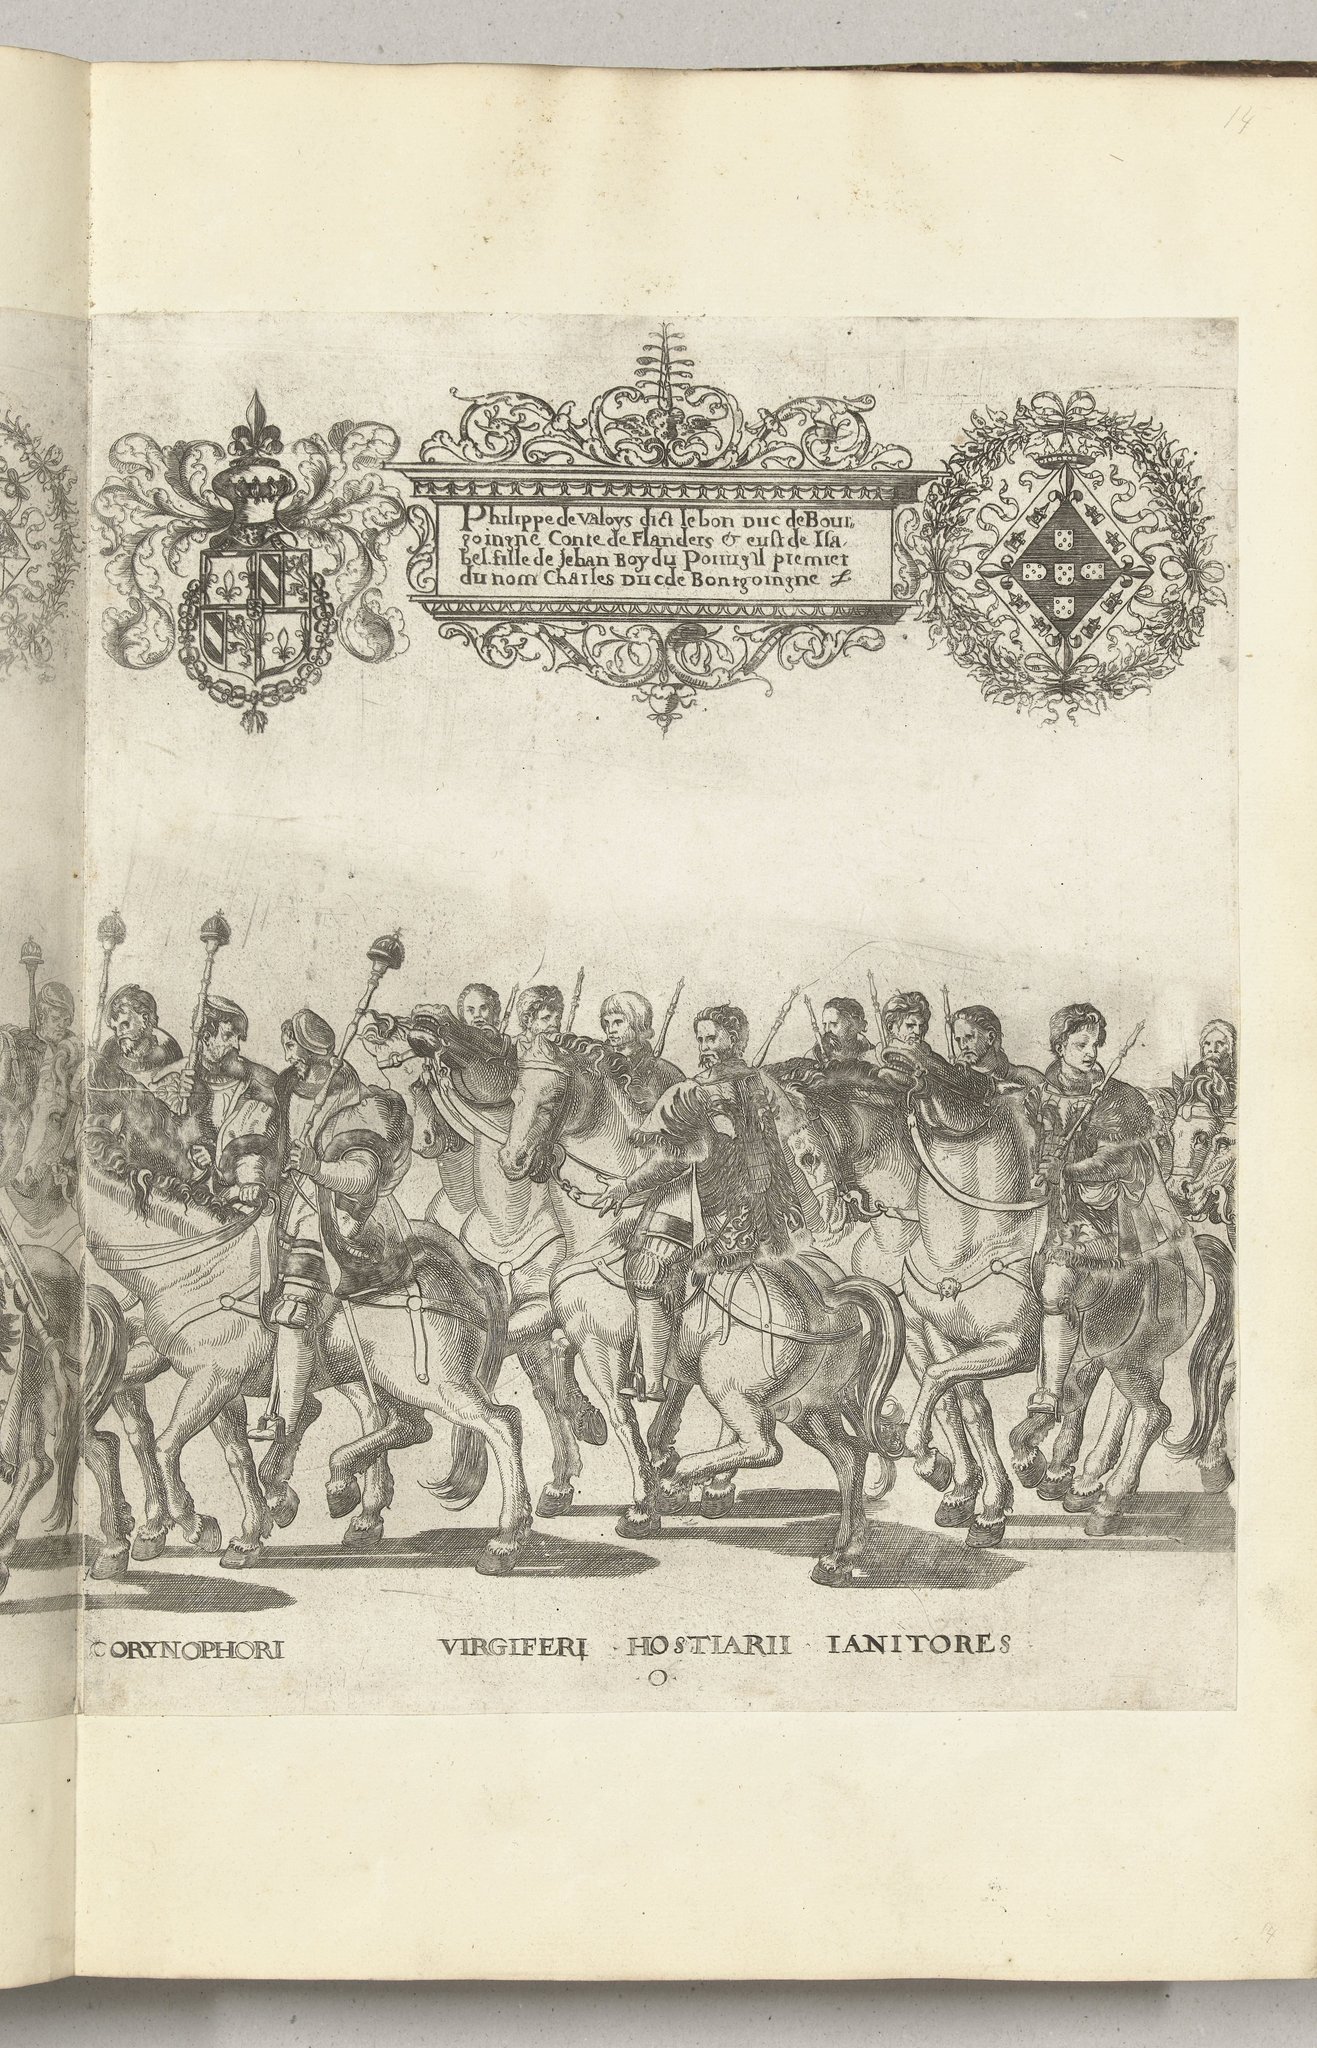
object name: print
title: Optocht van Karel V met de paus te Bologna na zijn kroning to keizer, 1530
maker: nicolaas hogenberg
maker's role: draughtsman, painter, print maker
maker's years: 1500-1539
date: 1530-1536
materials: paper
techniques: etching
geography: mechelen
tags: ghent, charles v (holy roman emperor and king of spain), rome, festivities (+ parade, pageant, cavalcade ~ festive activities)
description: Prent in het album waarin zijn ingeplakt de 40 platen die achterelkaar samen het fries vormen van de optocht van Karel V met de paus Clemens VII te Bologna na zijn kroning tot keizer, 24 februari 1530.